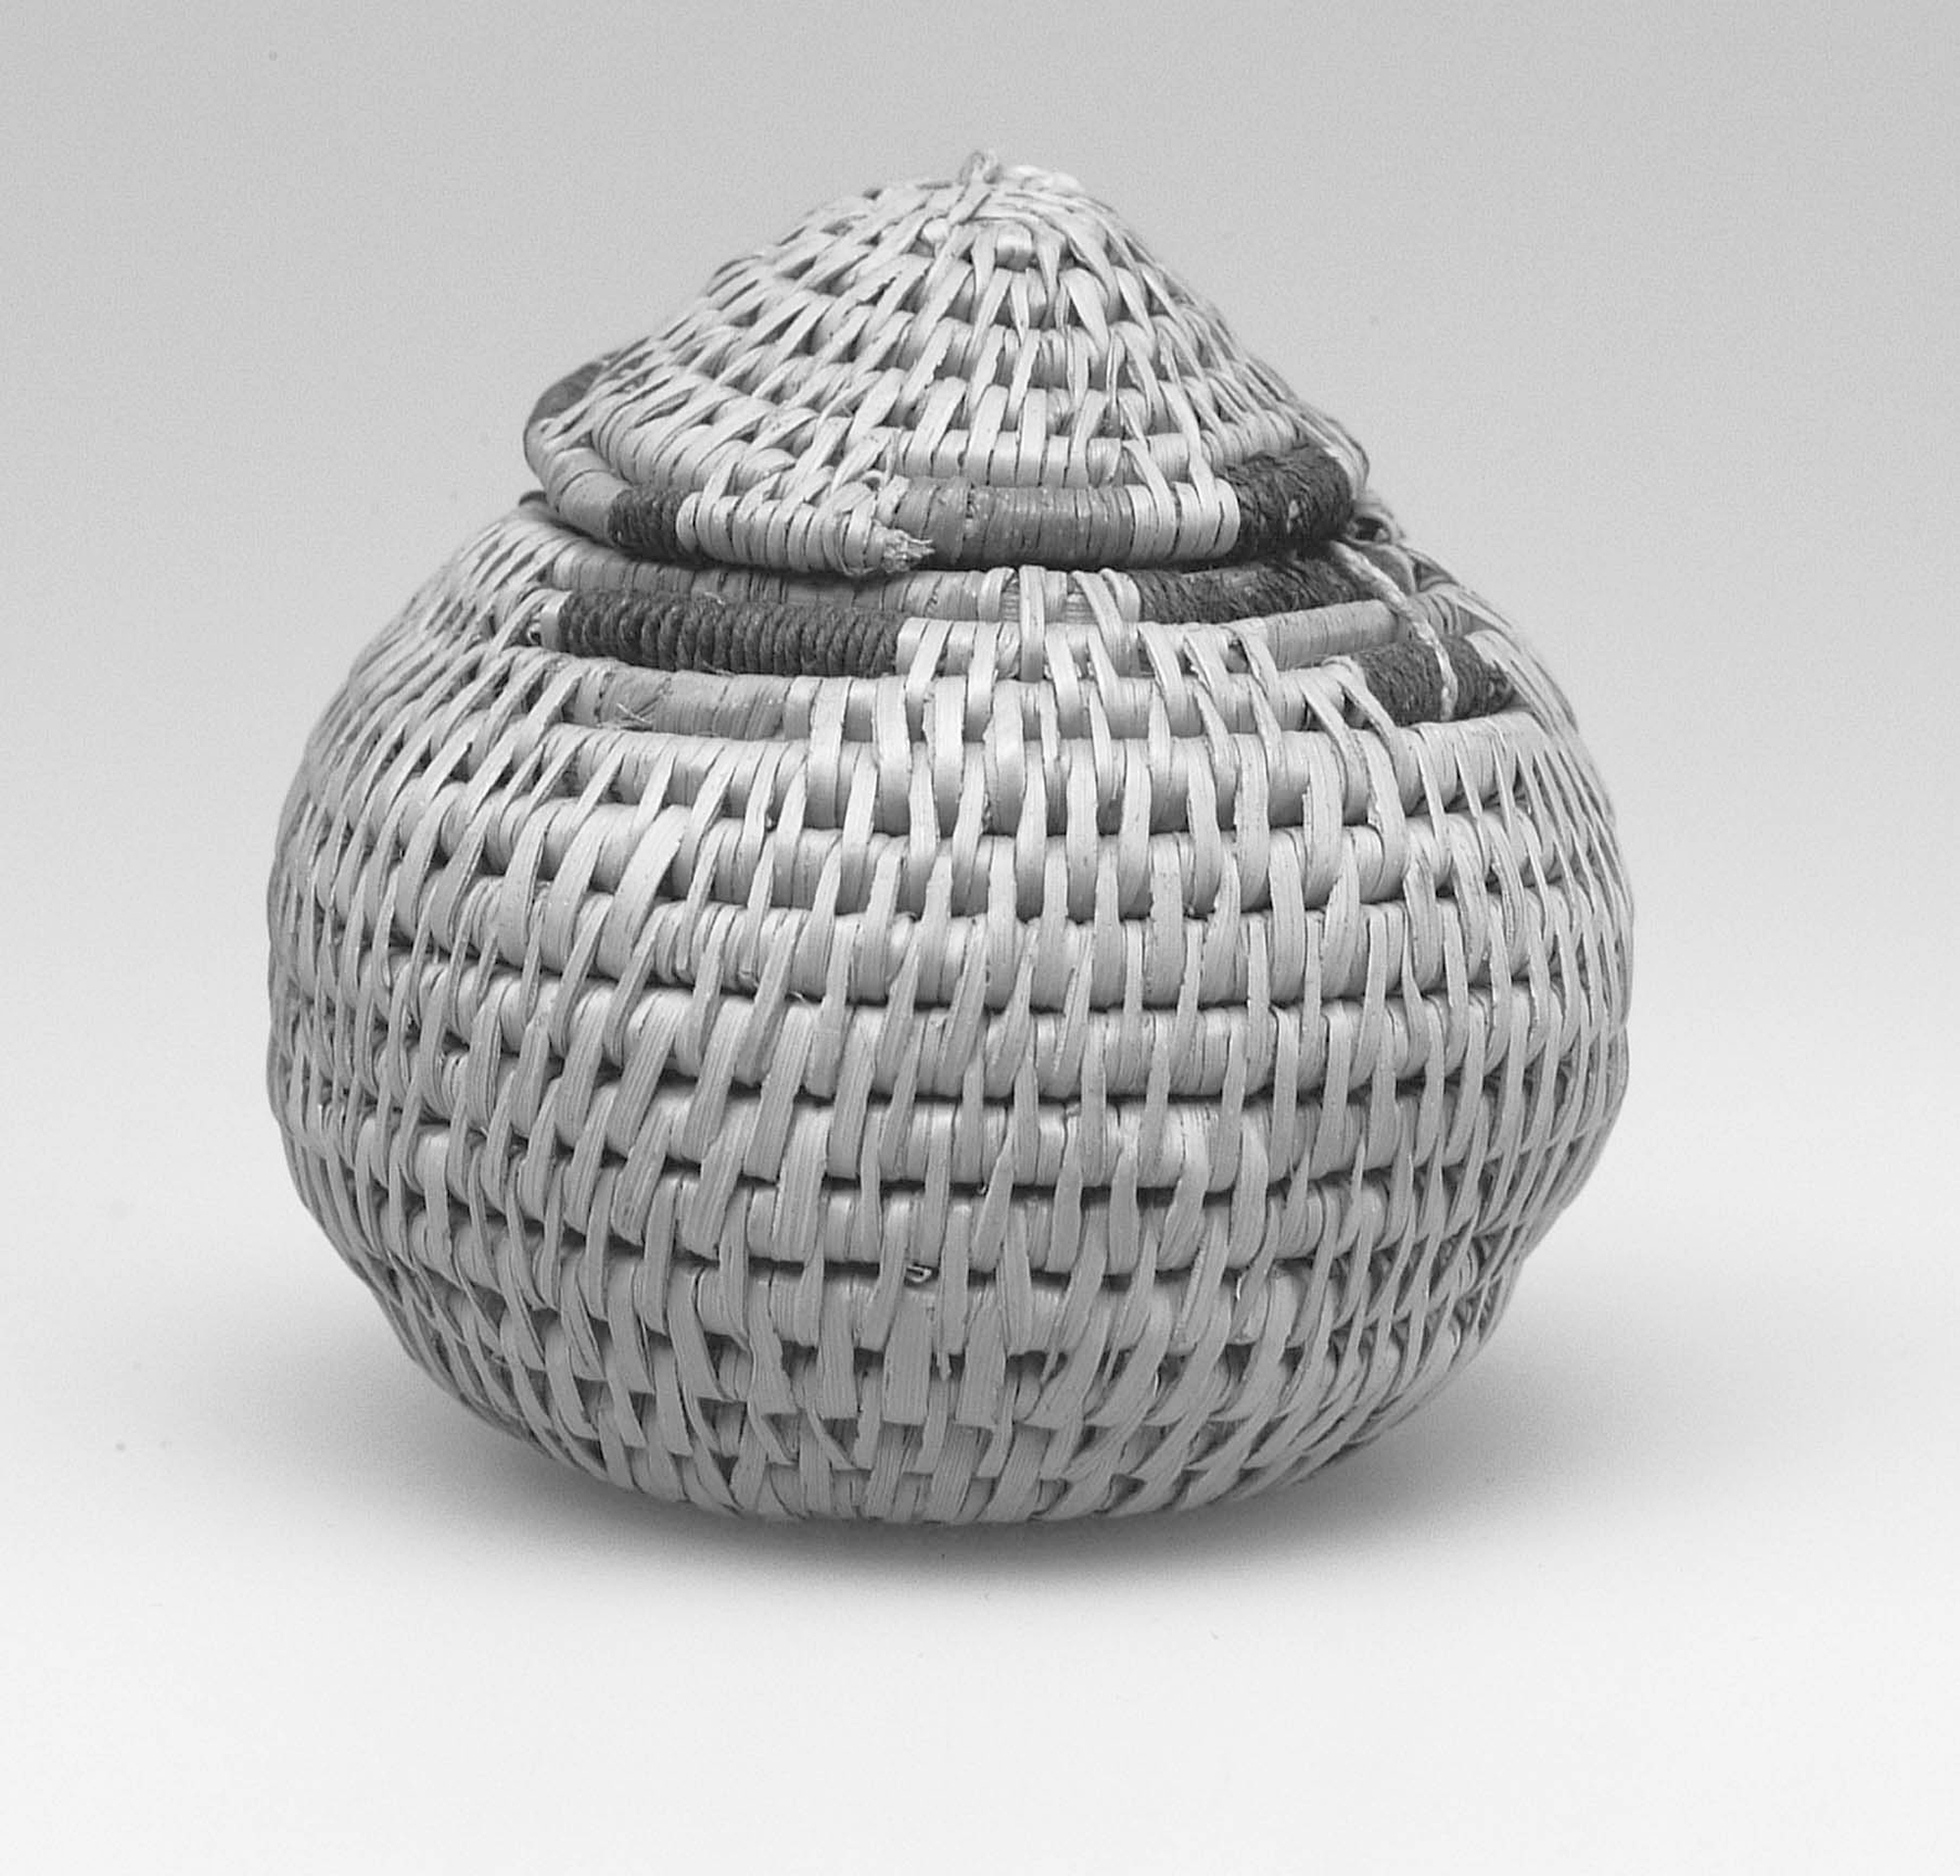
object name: basket, lid contained 22. 3. 65c h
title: Basket with Lid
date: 712-525 BCE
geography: egypt